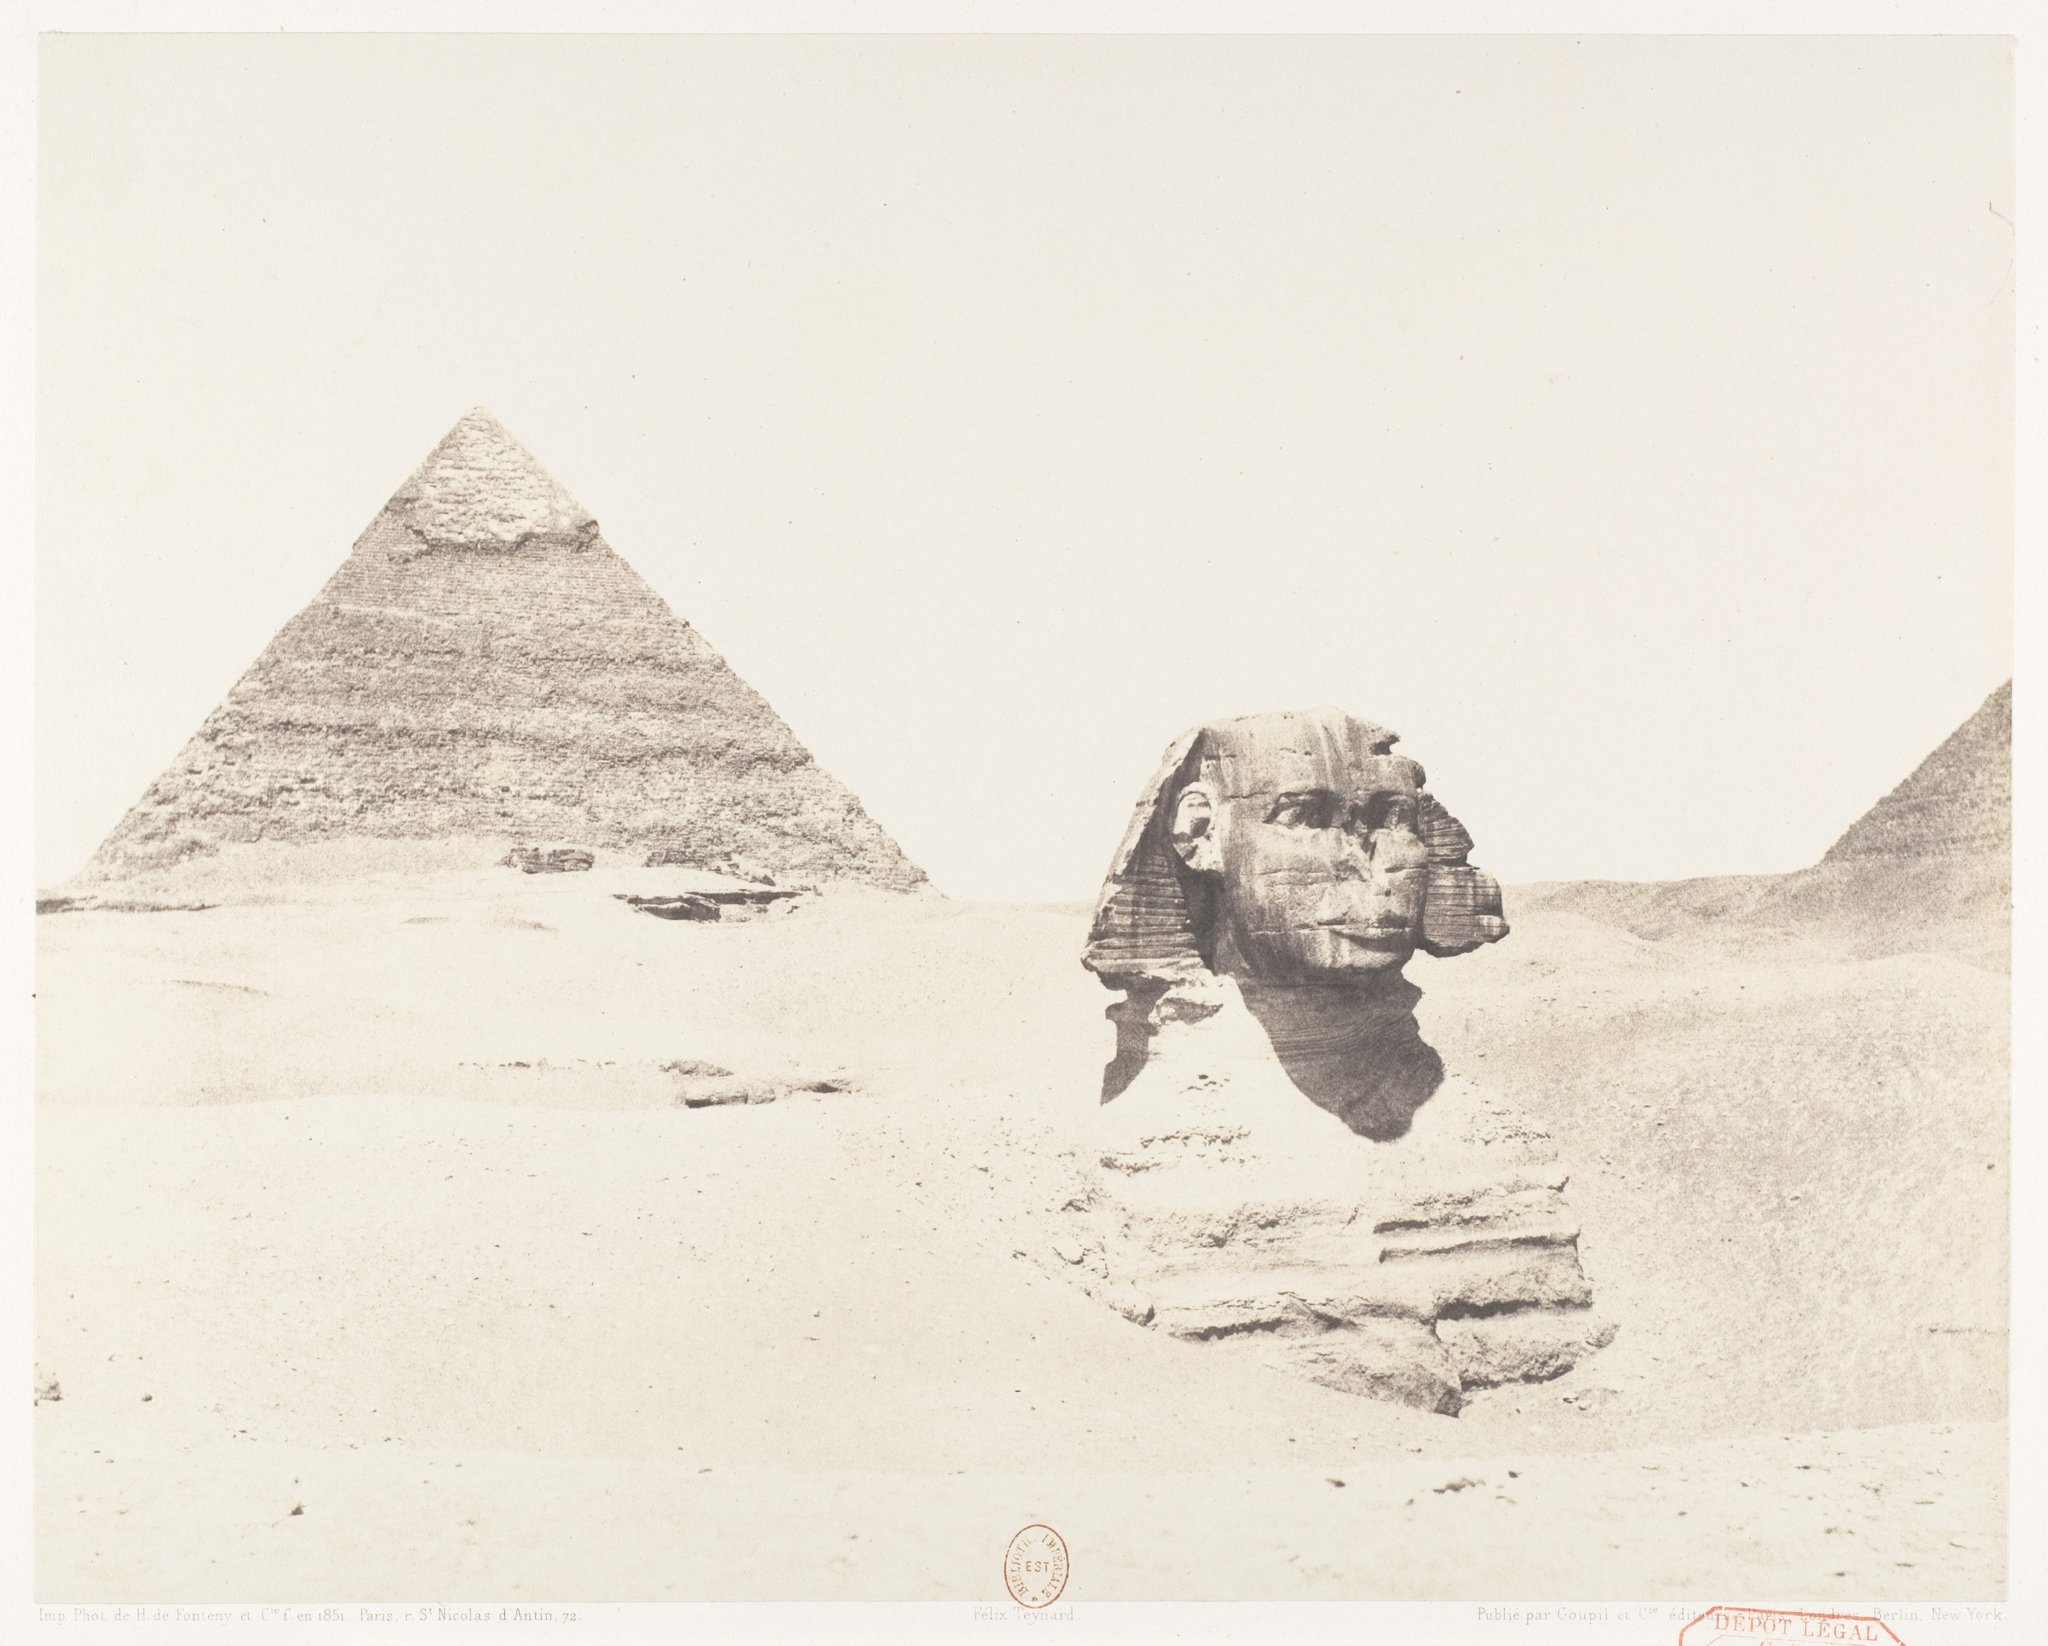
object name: photograph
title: Djîzeh (Nécropole de Memphis), Sphinx et Pyramides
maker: félix teynard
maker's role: artist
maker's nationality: french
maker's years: 1817-1892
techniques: paper negative, salted paper print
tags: ruins,pyramids,sphinx